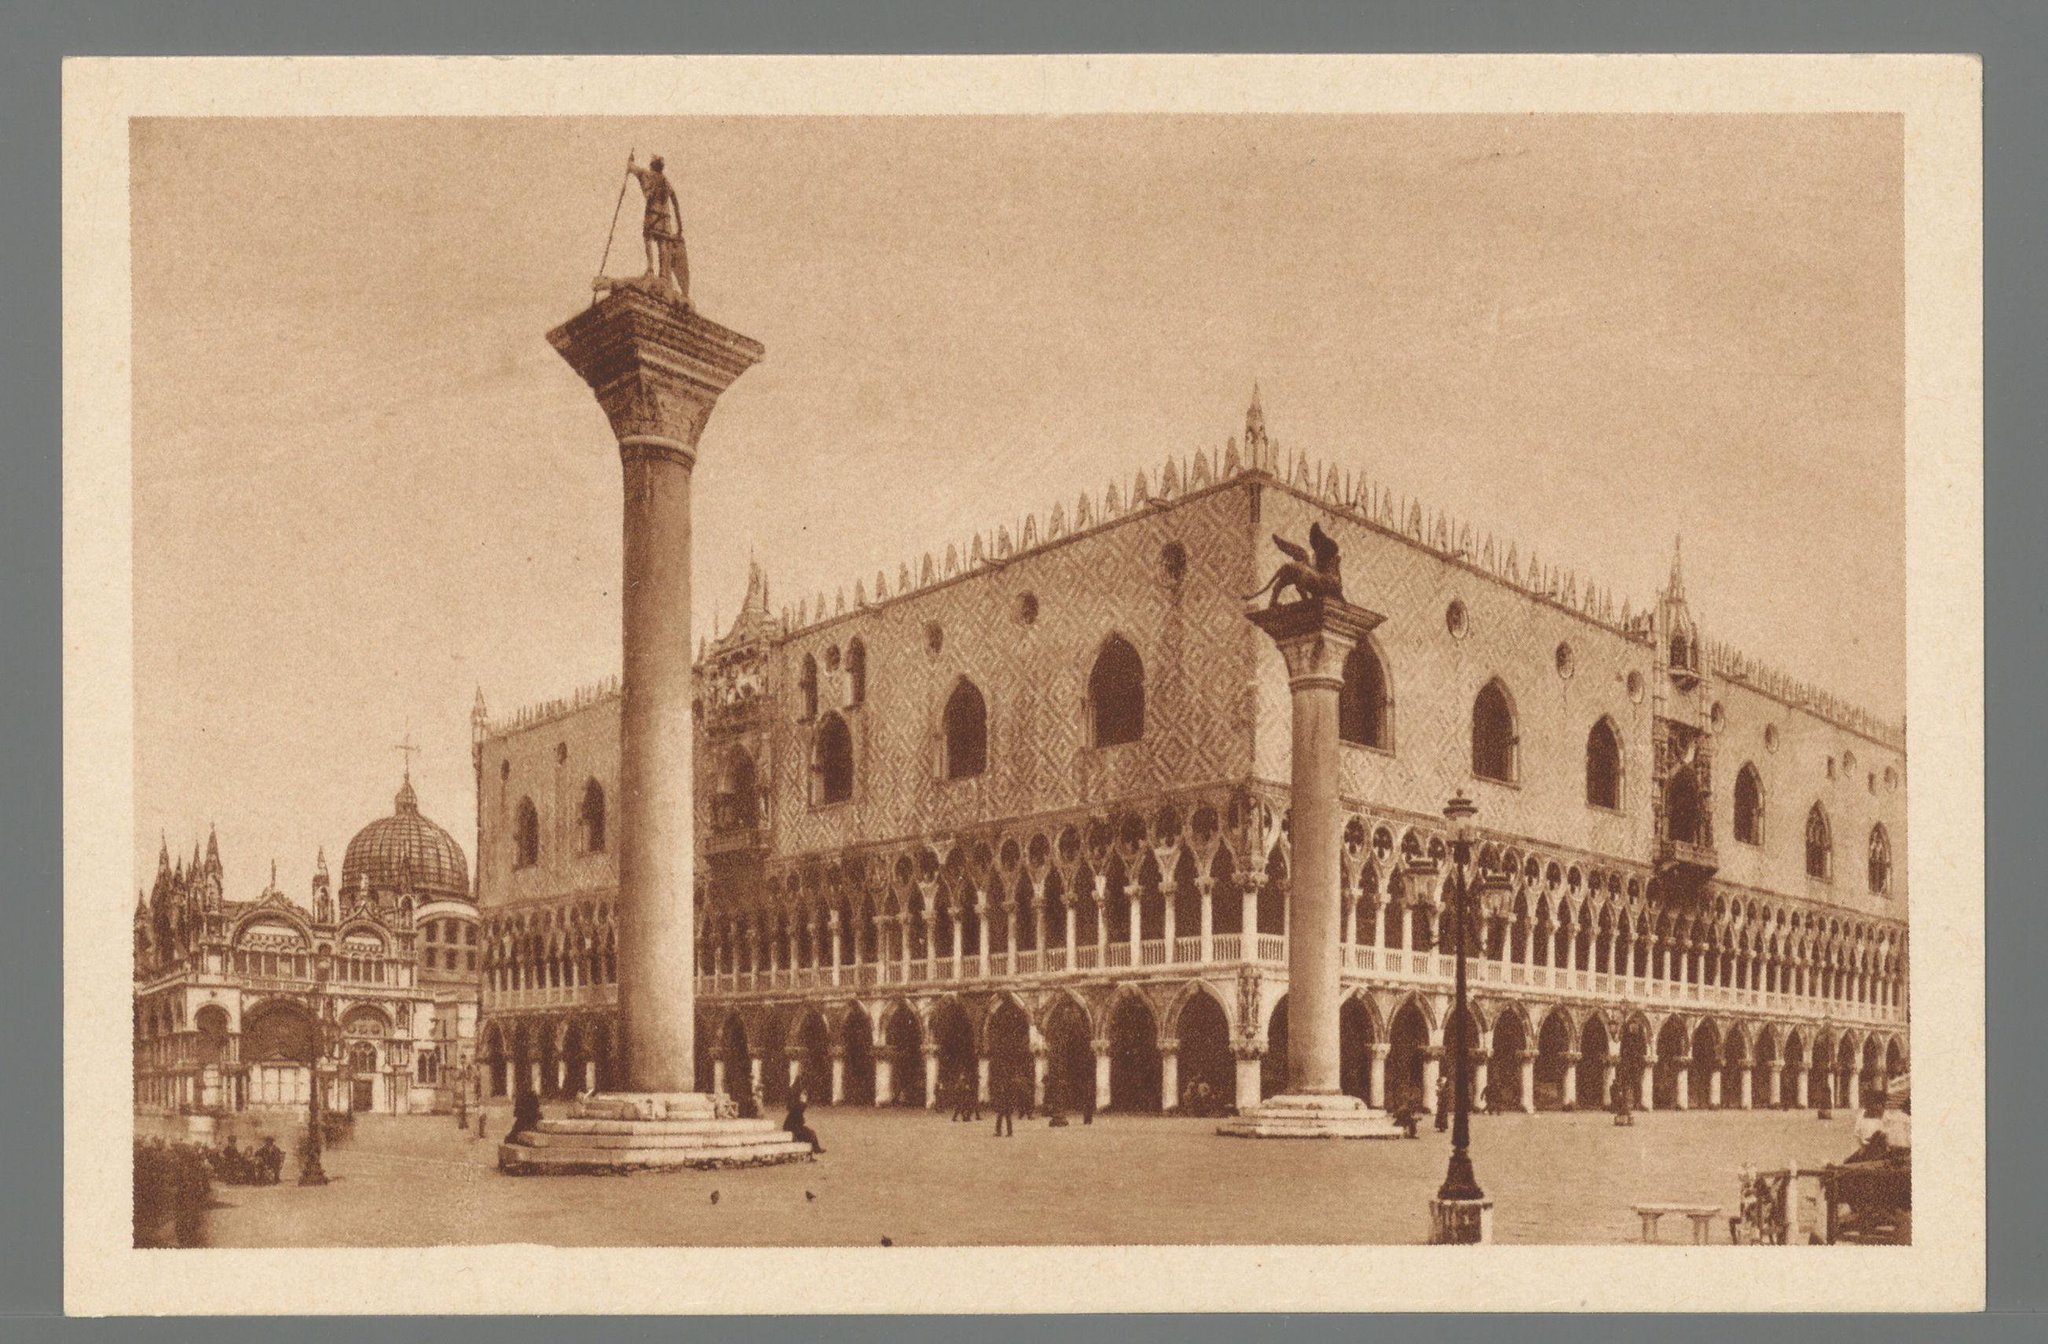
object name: ansichtkaart, prentbriefkaart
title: Venezia. Palazzo Ducale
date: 1906-1930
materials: cardboard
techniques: rotogravure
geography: venice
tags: palace, square, place, circus, etc. (+ city(-scape) with figures, staffage)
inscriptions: collector's mark: ‘AFE v S’